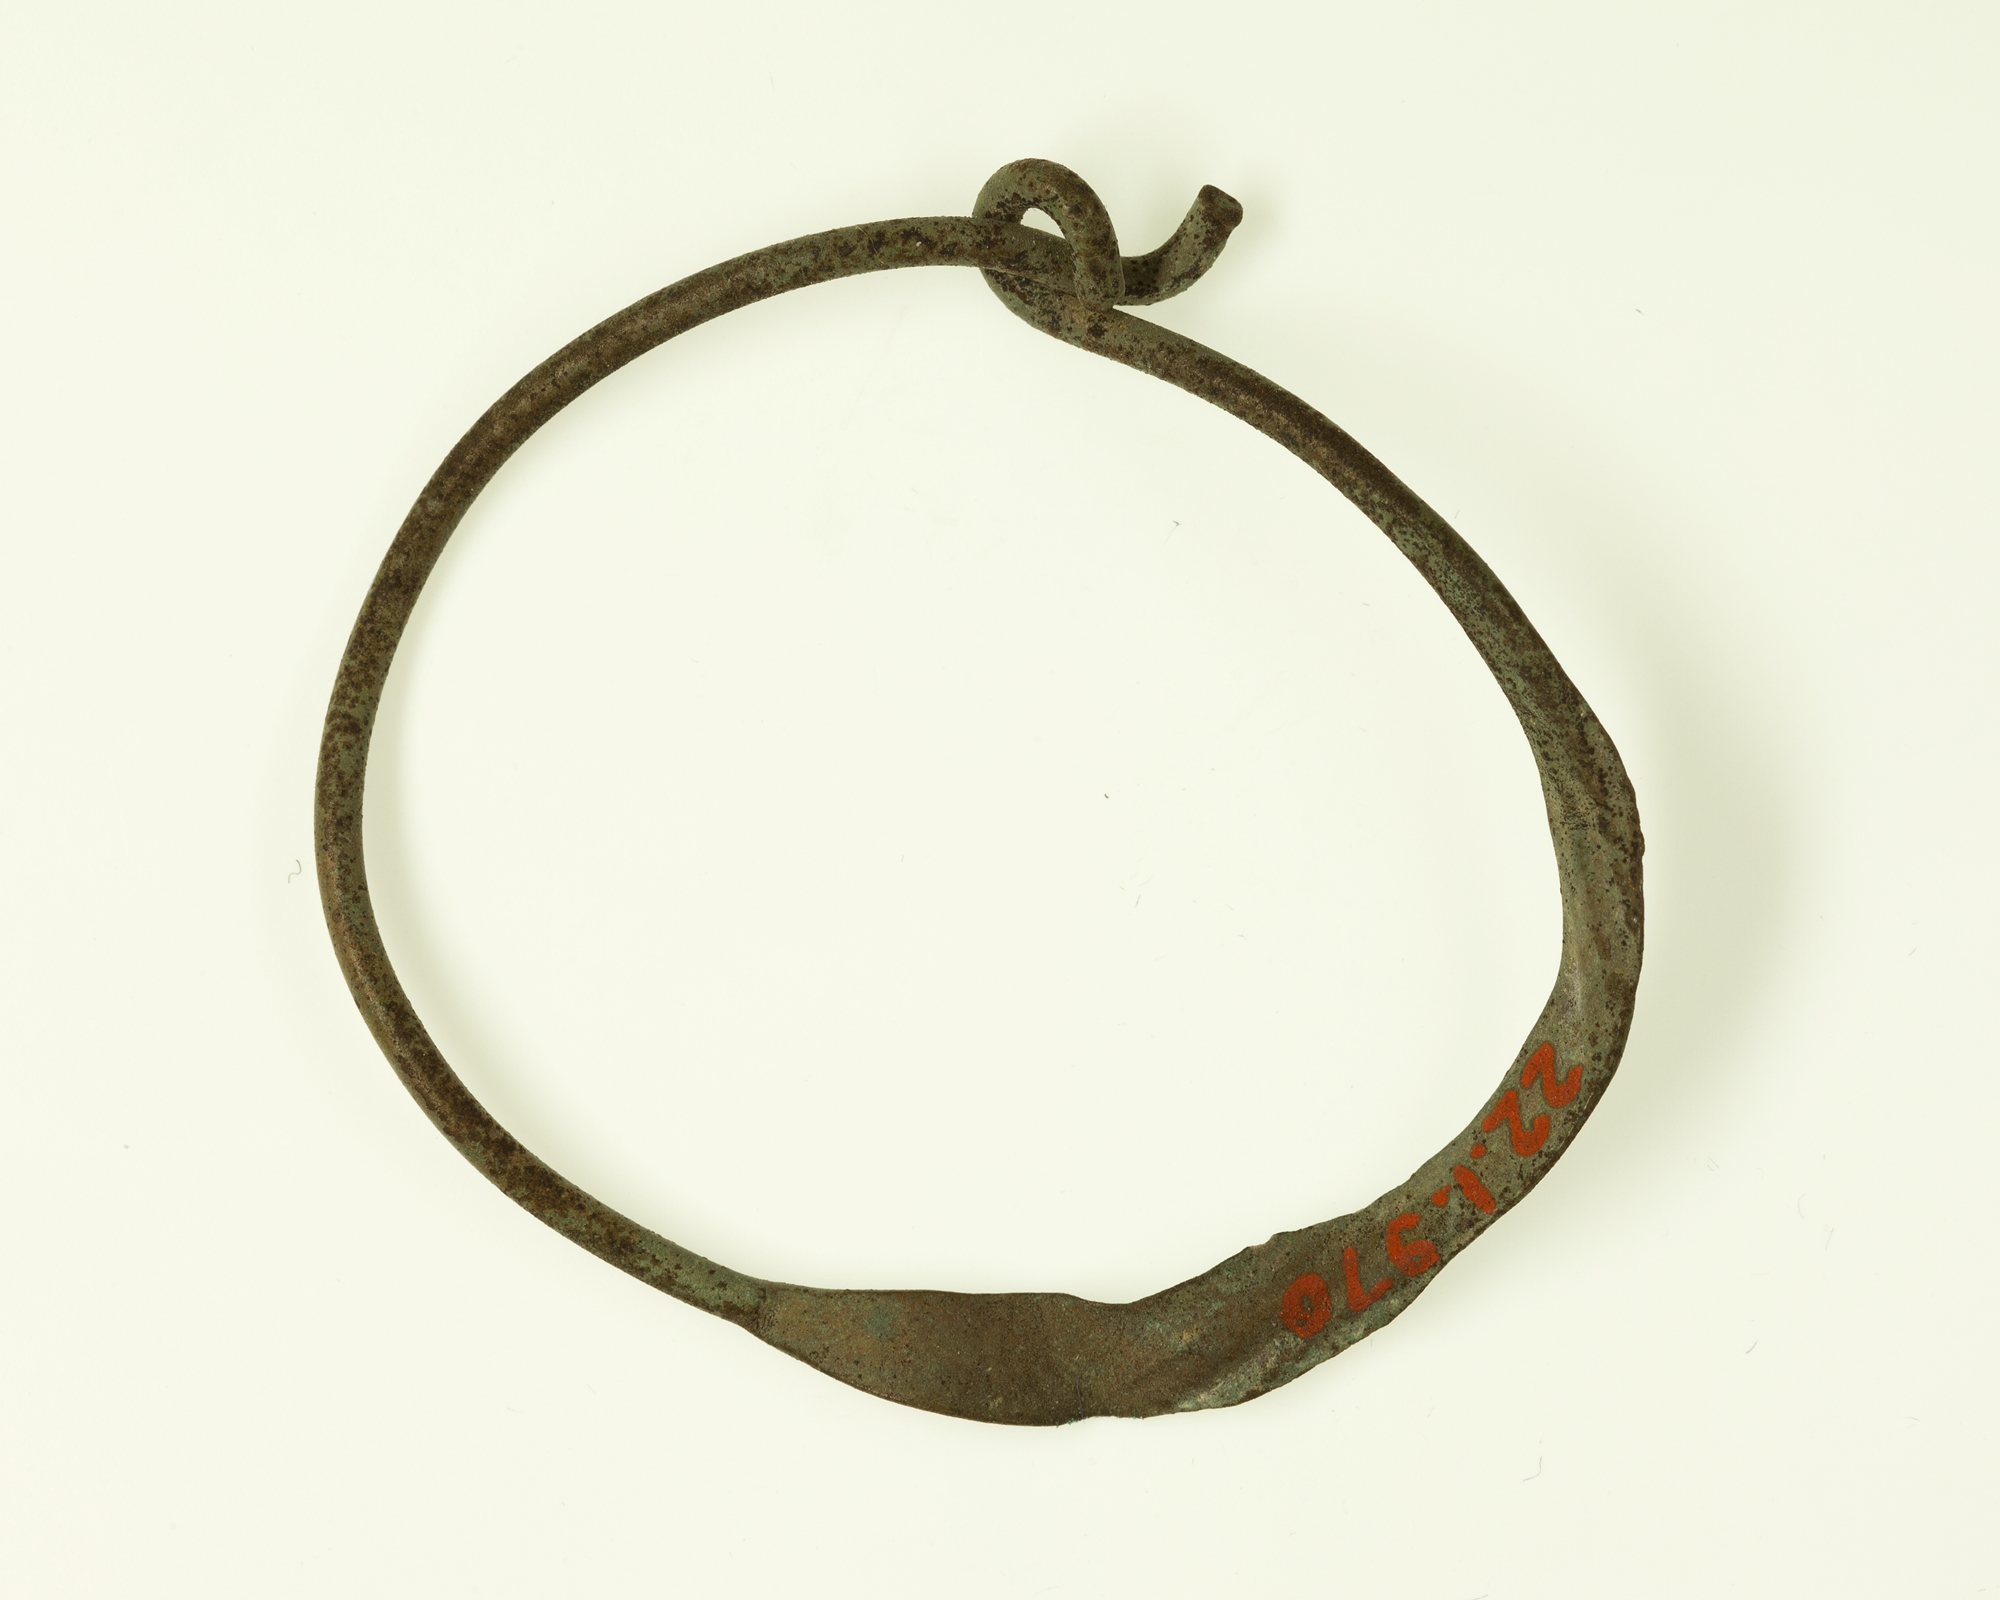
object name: household ring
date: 1295-1070 BCE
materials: bronze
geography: egypt